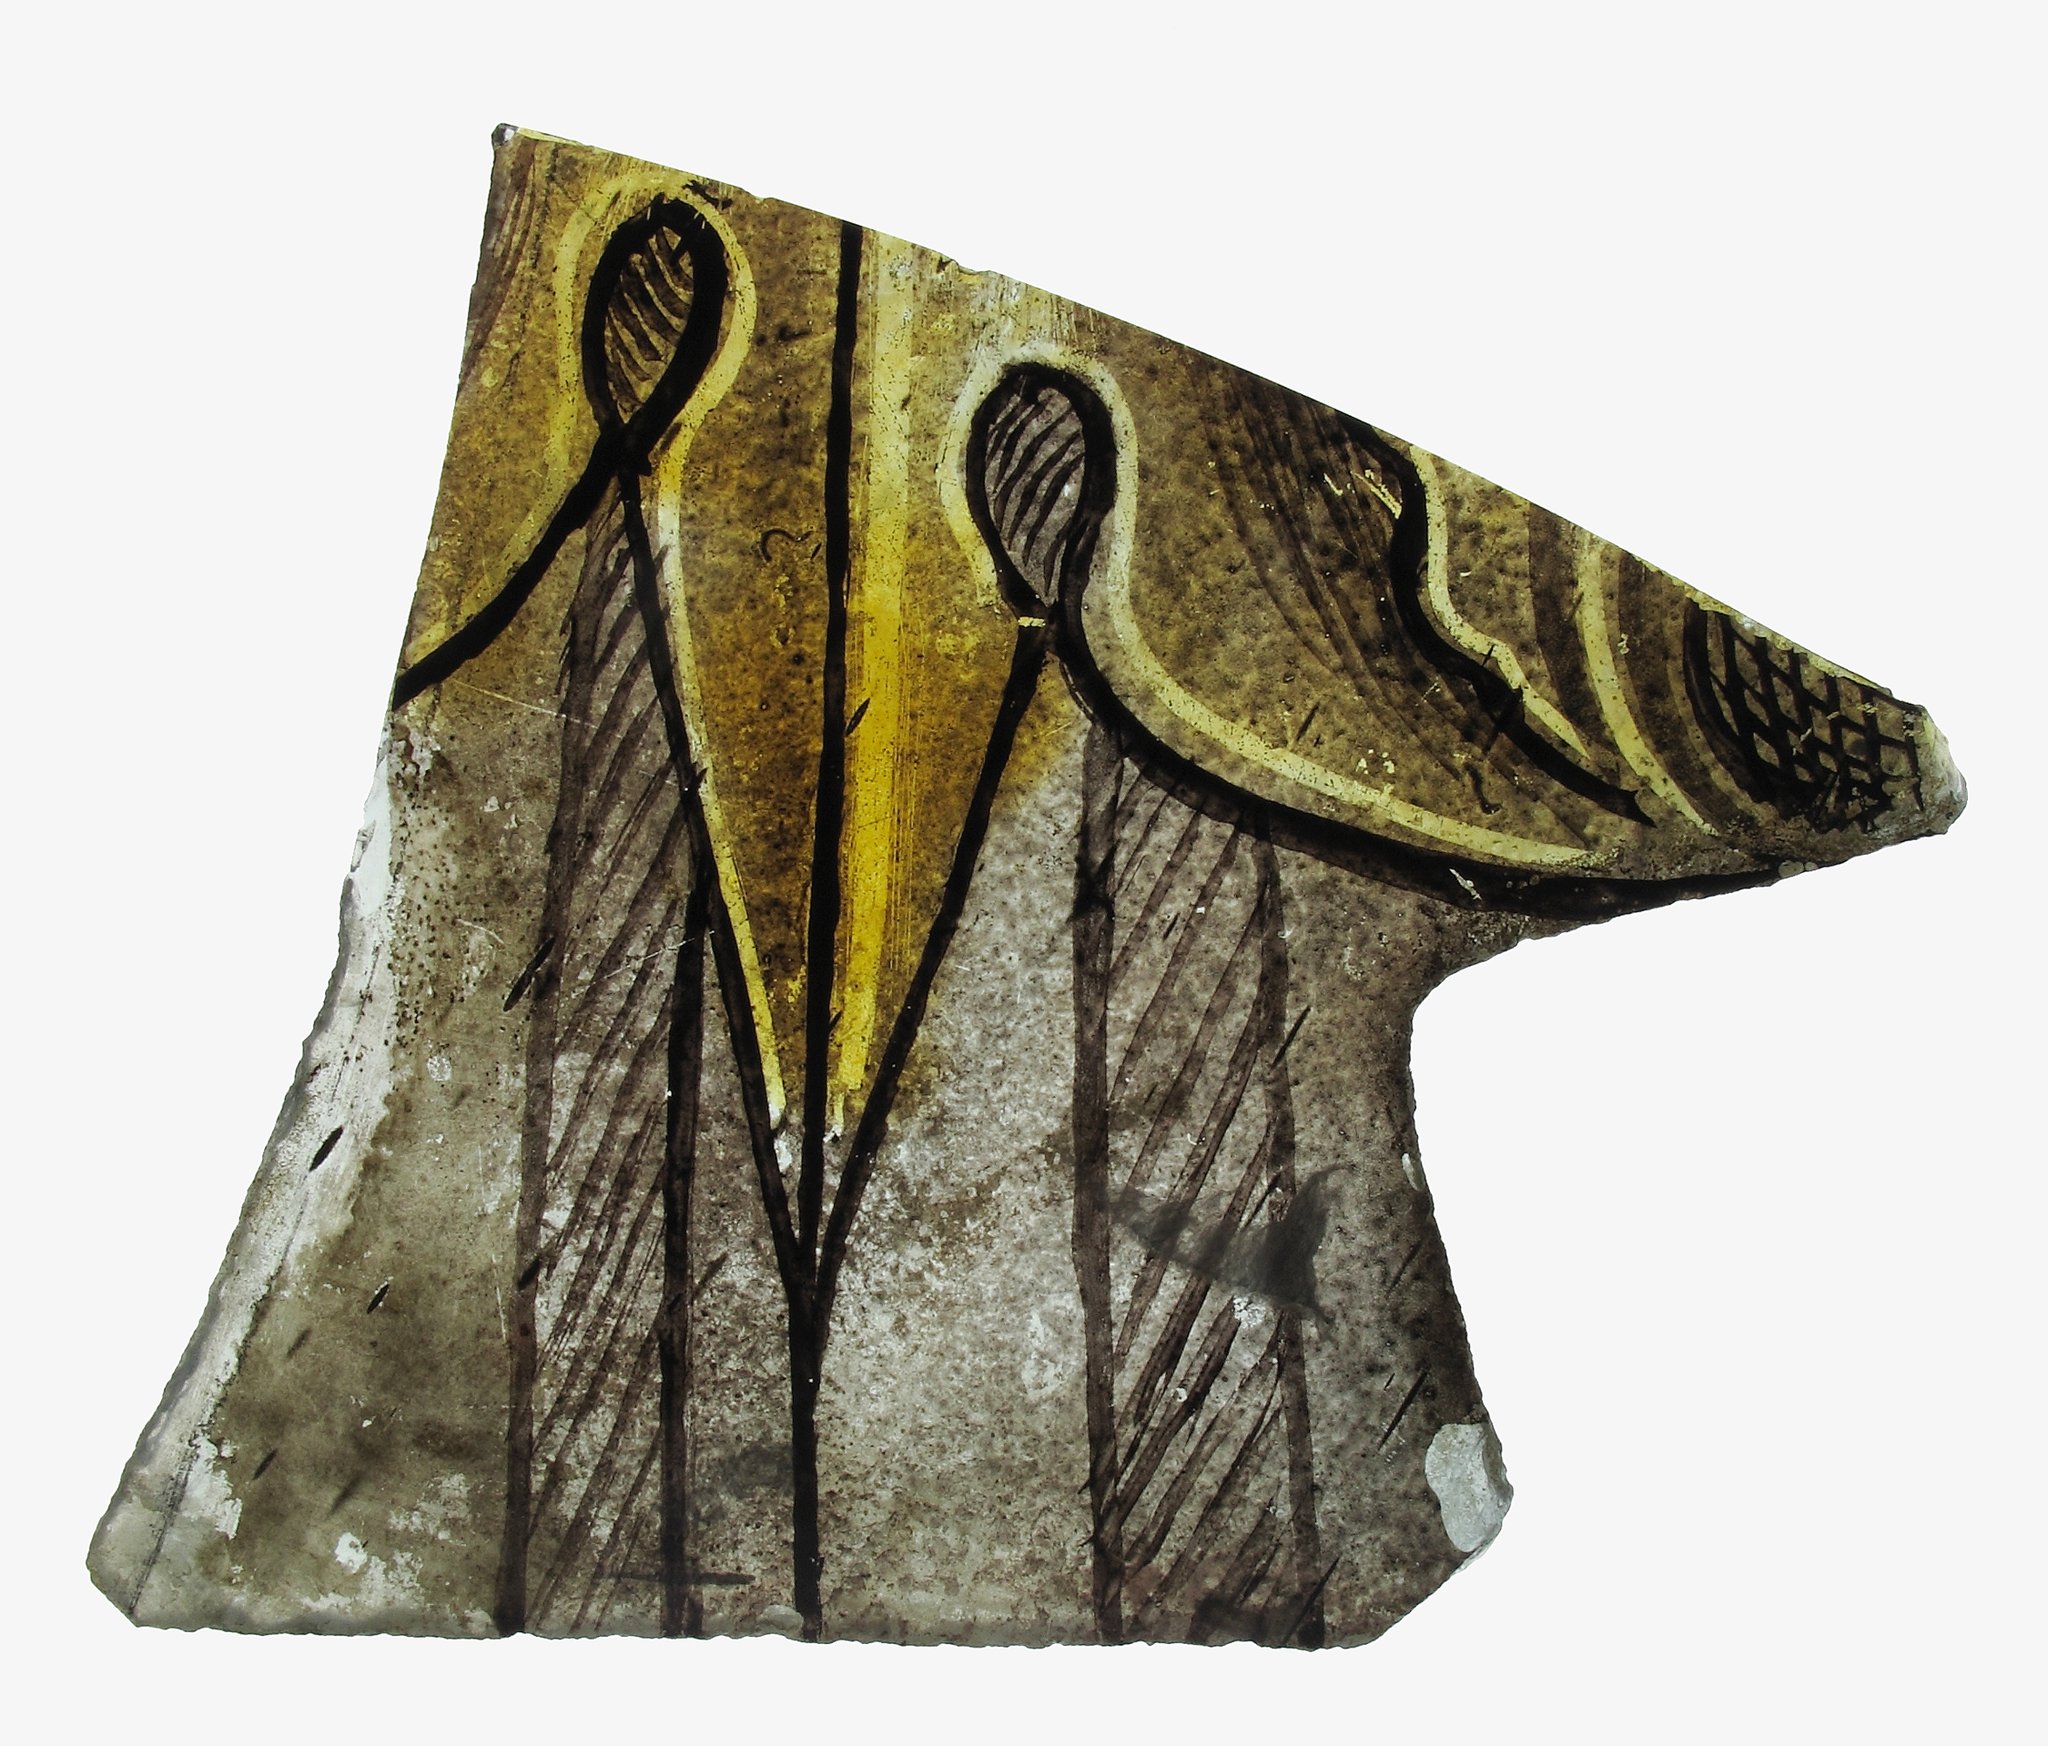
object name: fragment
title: Glass Fragment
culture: european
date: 1401-1600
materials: glass, pigment